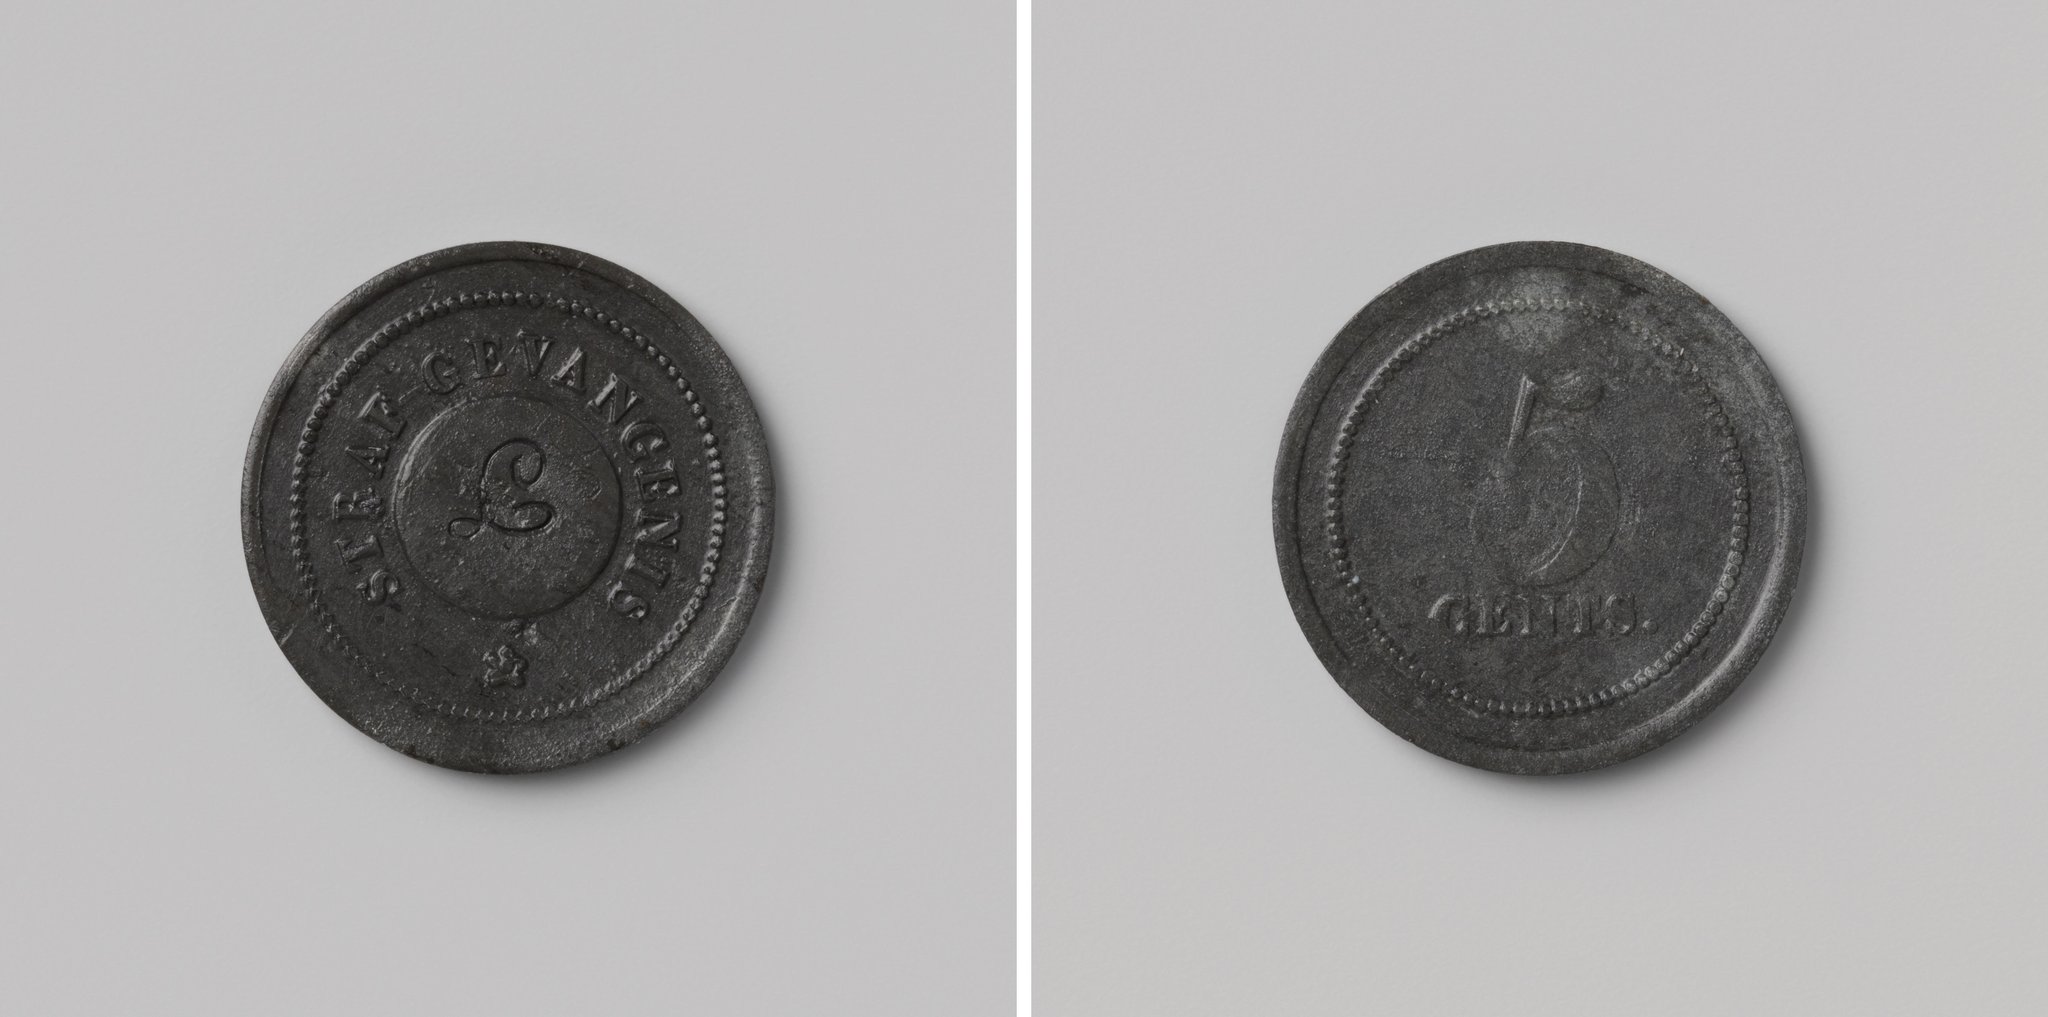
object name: monetary token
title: Strafgevangenis te Leeuwarden, huismunt ter waarde van vijf cents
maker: Anonymous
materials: zinc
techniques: striking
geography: utrecht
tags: leeuwarden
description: Zinken betaalpenning. Voorzijde: letter L binnen omschrift. Keerzijde: waardeaanduiding.